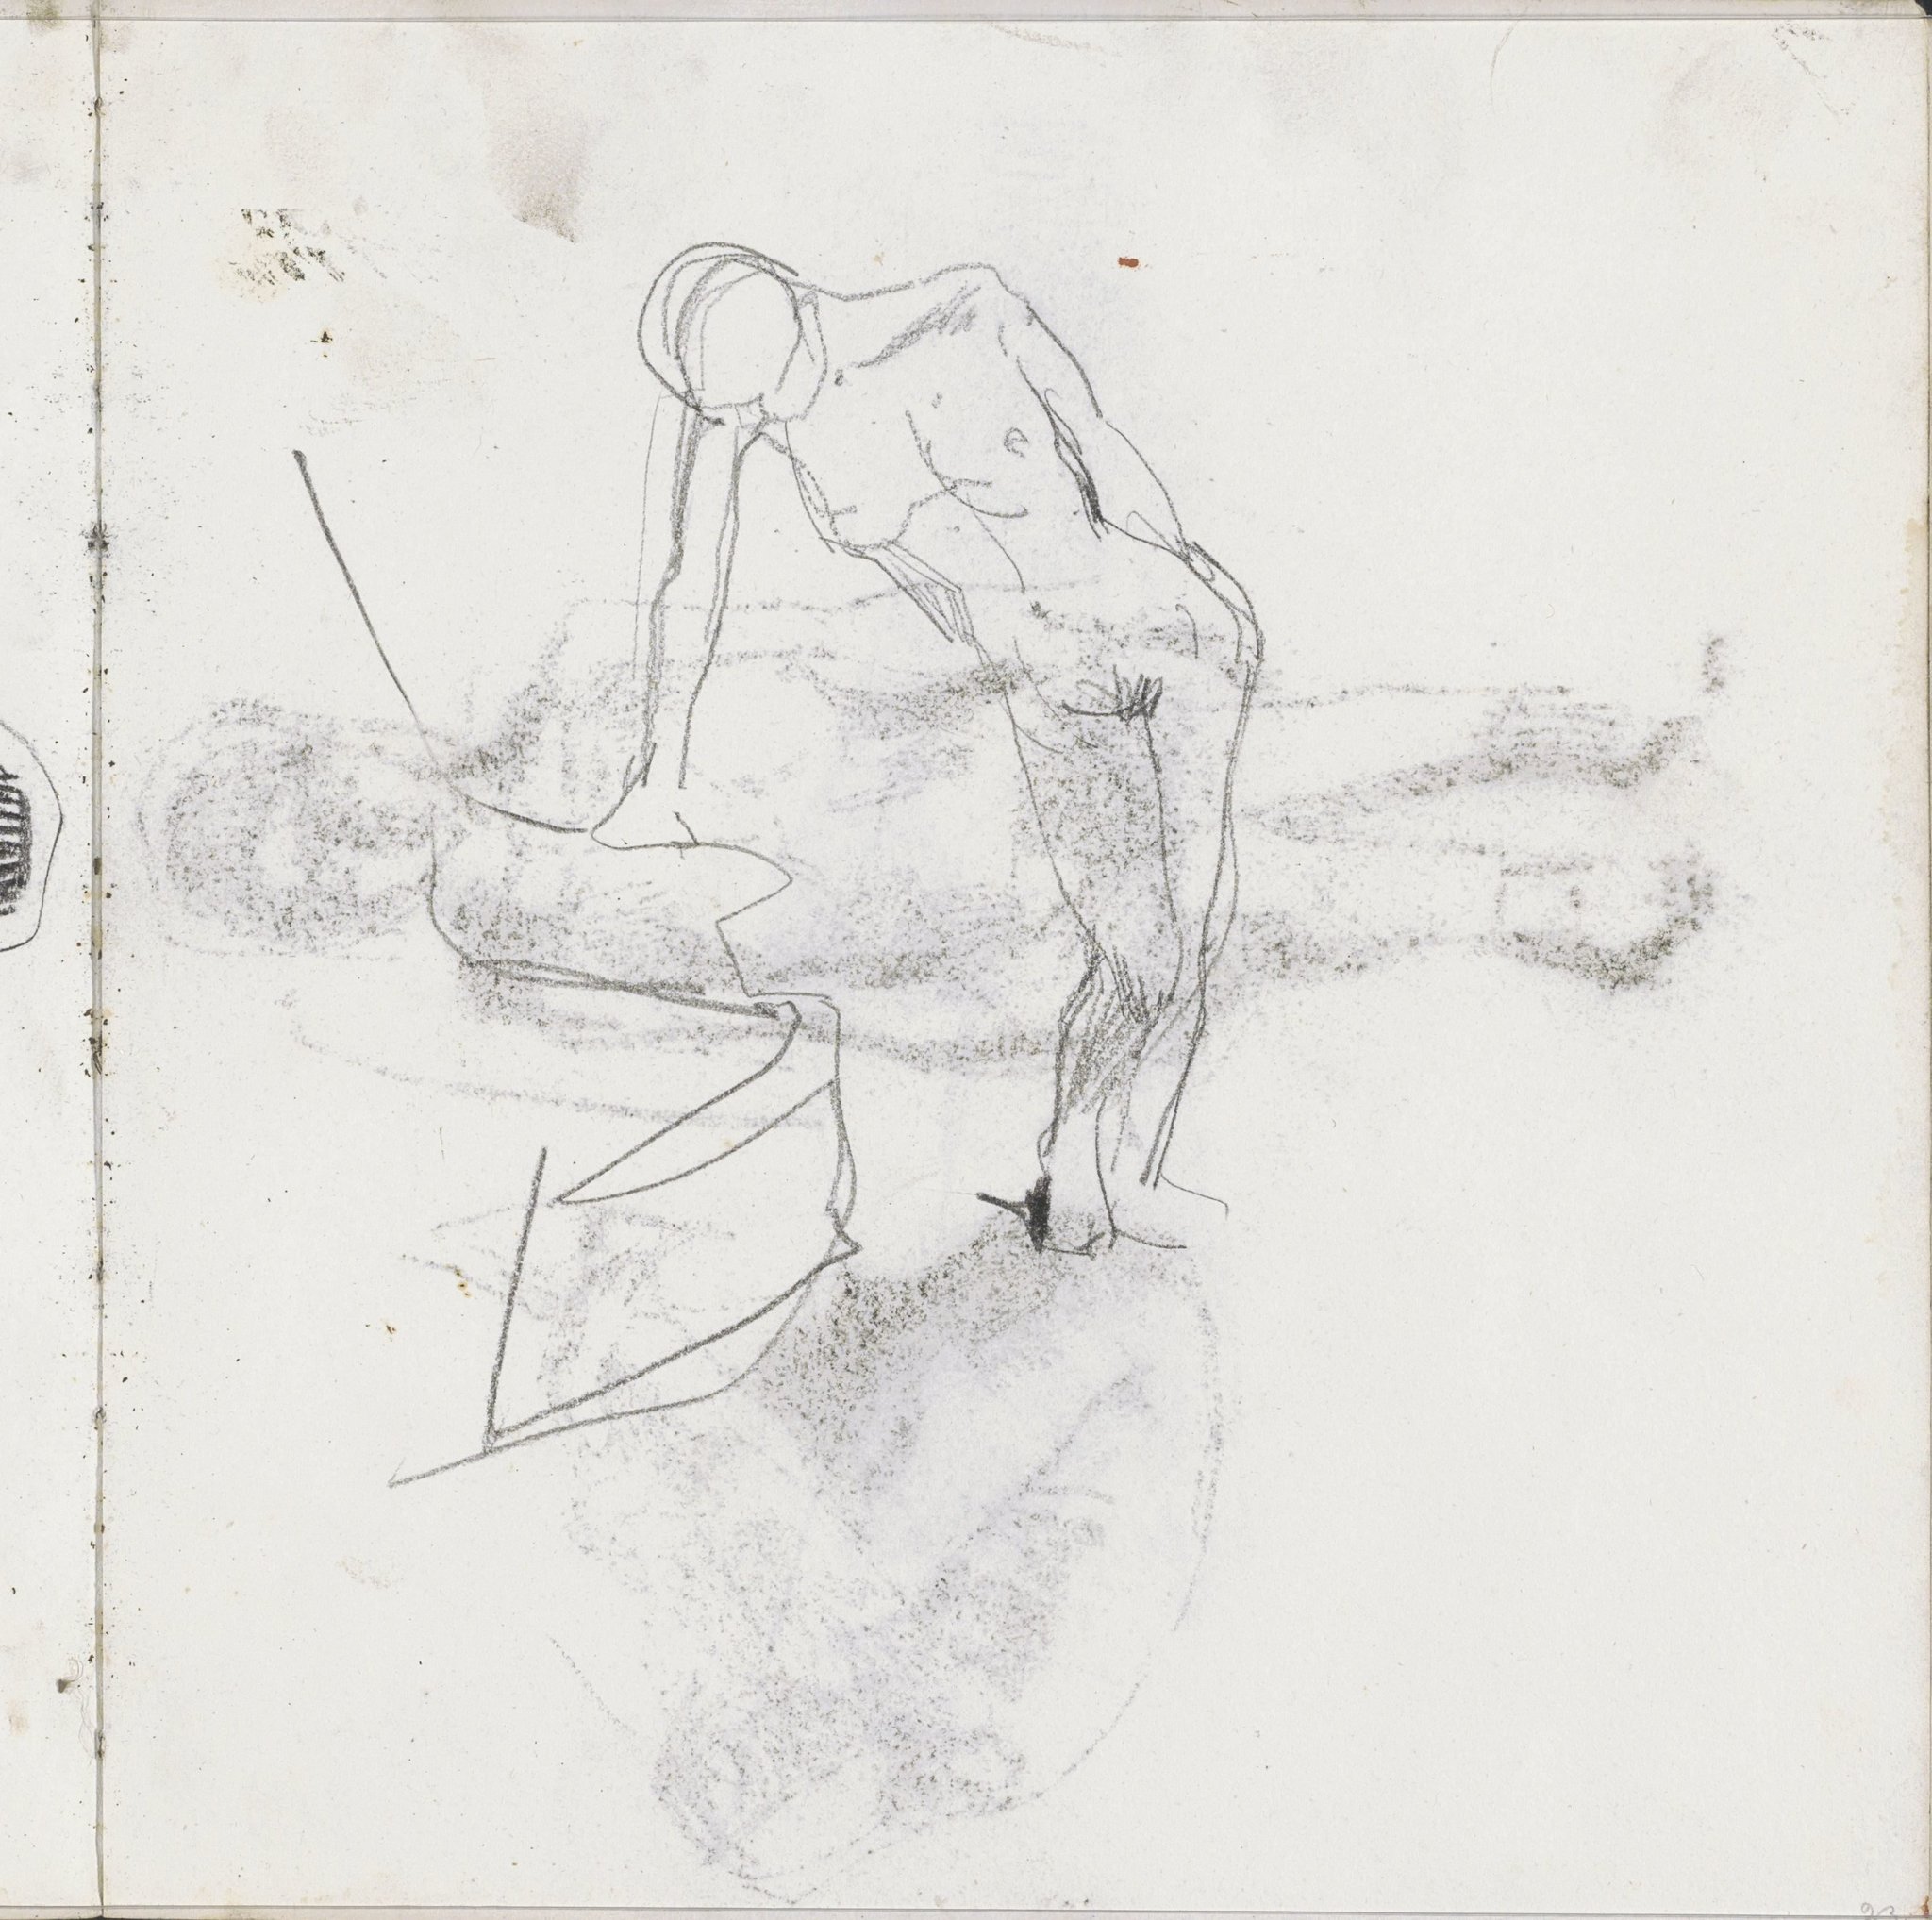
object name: sketchbook leaf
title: Staand vrouwelijk naakt, leunend op een fauteuil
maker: isaac israels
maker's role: draughtsman, painter, print maker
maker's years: 1865-1934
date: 1875-1934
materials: chalk, paper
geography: the hague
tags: armchair, seat, the (nude) human figure; 'corpo humano' (ripa) - aa - female human figure (+ standing), leaning sideways - aa - female human figure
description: Blad 23 recto uit schetsboek IX met 28 bladen.